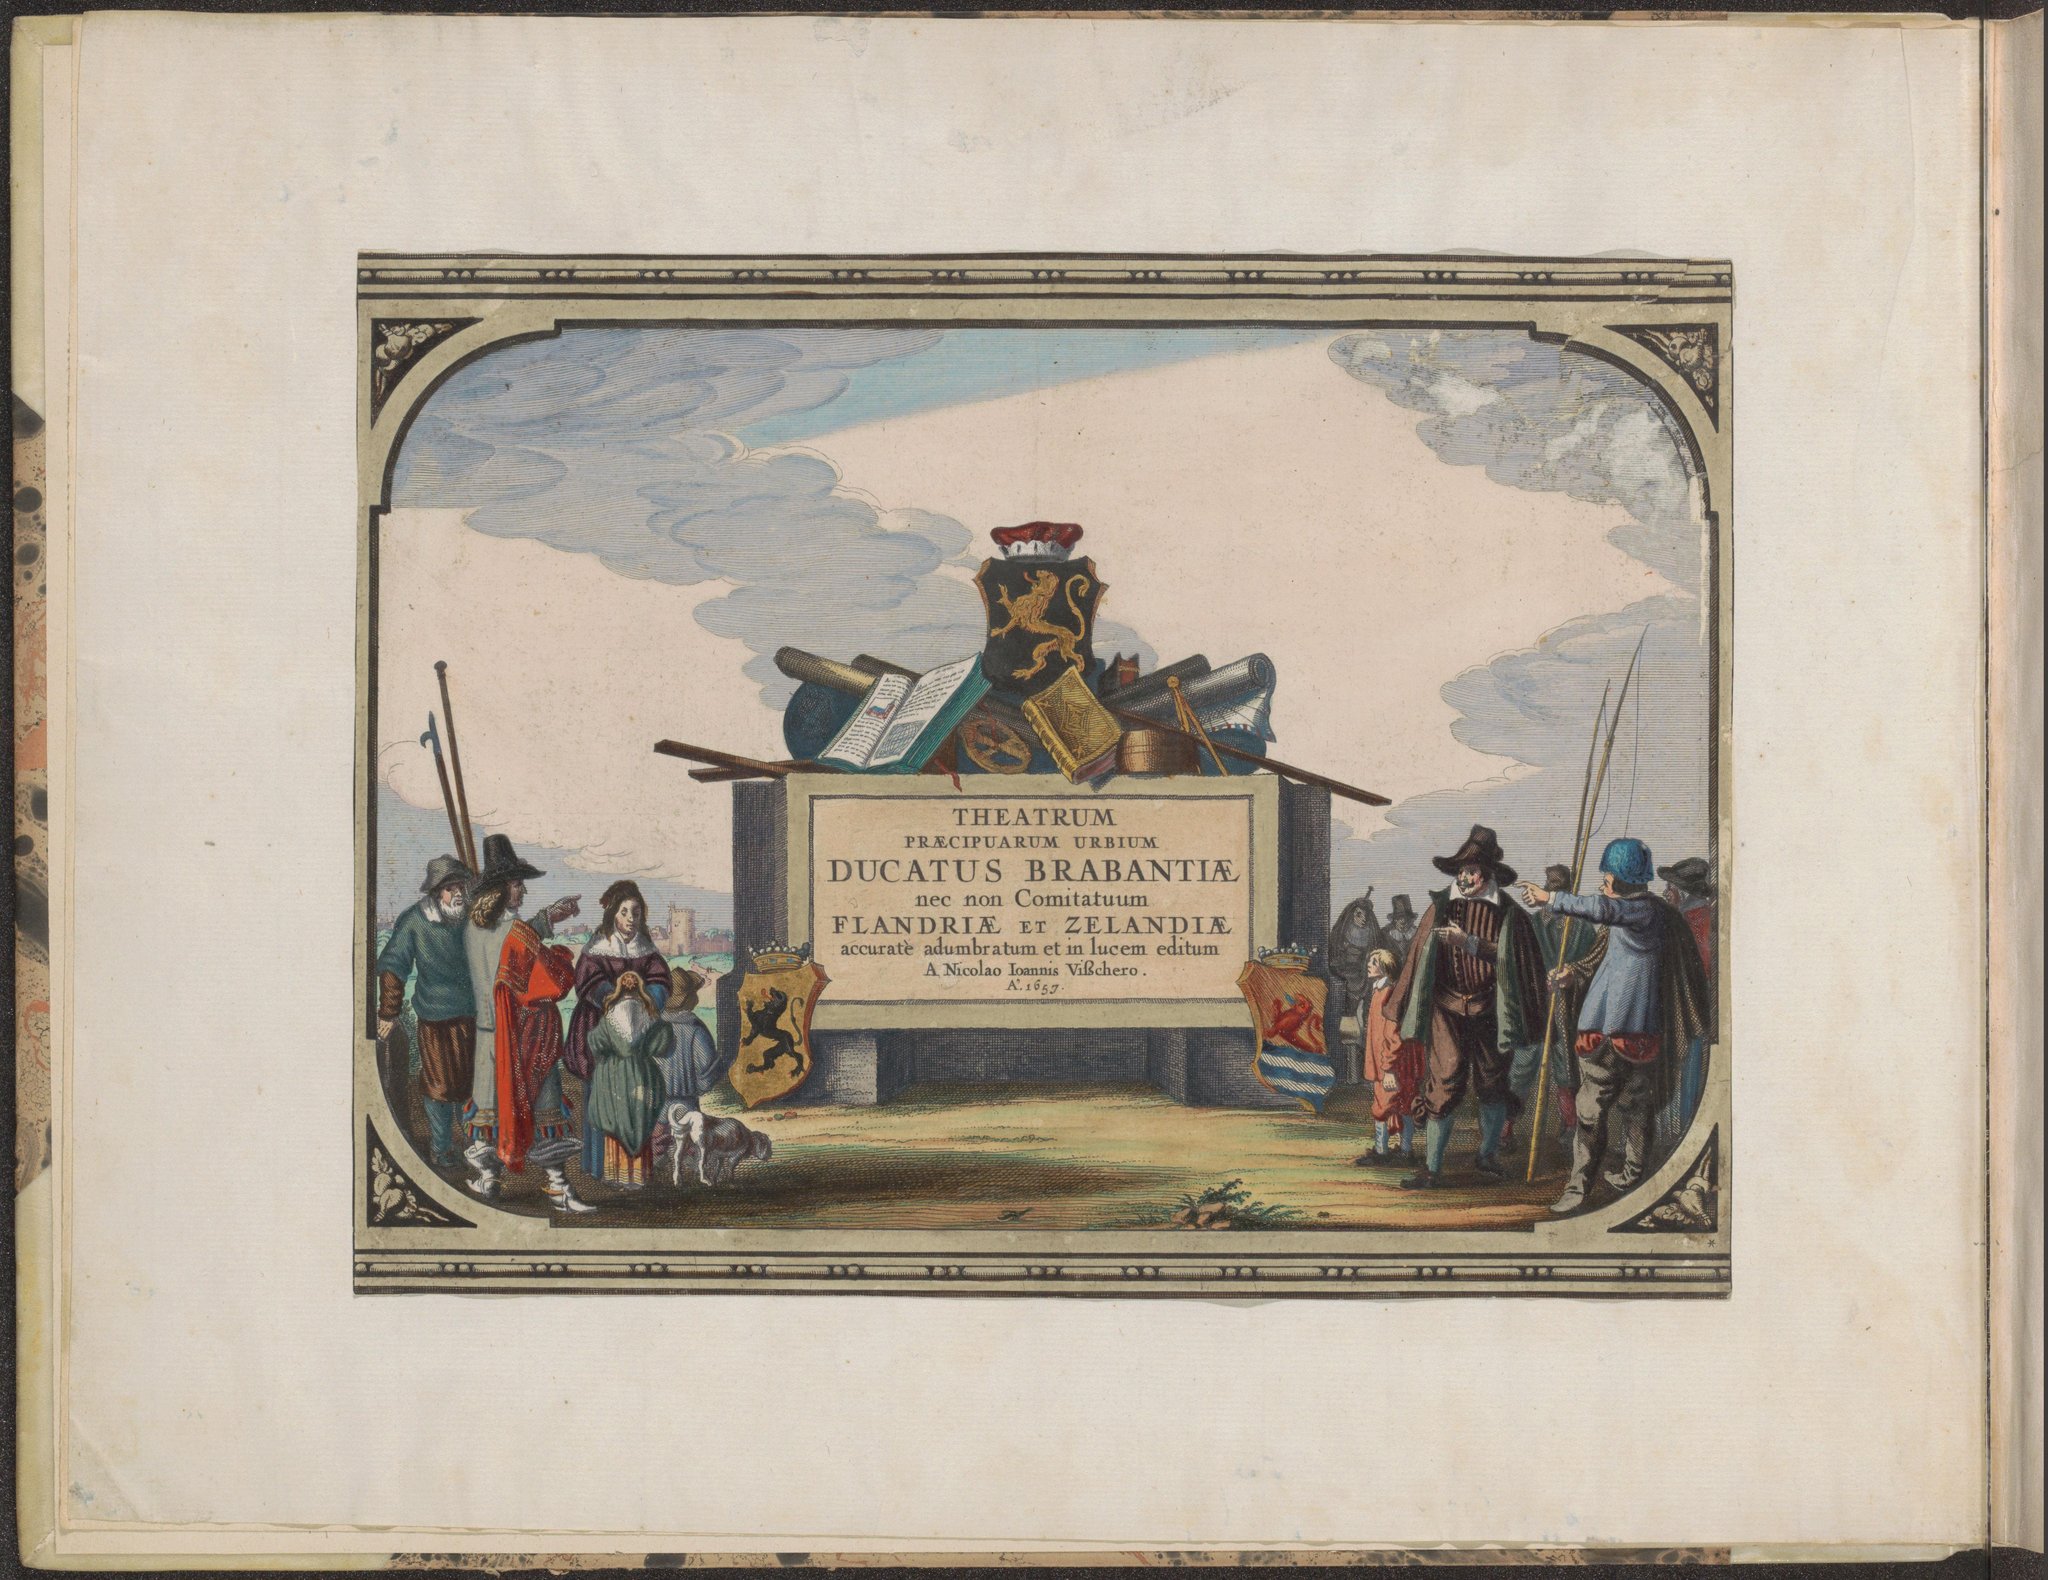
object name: album leaf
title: Theatrum praecipuarum urbium ducatus Brabantiae necnon comitatuum Flandriae et Zelandiae, 1660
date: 1657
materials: paper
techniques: etching, hand coloring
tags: coat of arms (as symbol of the state, etc.), maps, atlases, title-page, book - mm - book open, globe, fisherman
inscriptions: date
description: Verschillende mensen kijken en wijzen naar een monument met de titel van de serie: Theatrum praecipuarum .... Tegen het monument staan de wapenschilden van Vlaanderen en Zeeland. Bovenop een schild met het wapen van Brabant omgeven door objecten die steden beschrijven: boeken, kaarten, globes, meetinstrumenten. Rechts een visser met twee hengels. De prent maakt deel uit van een album.